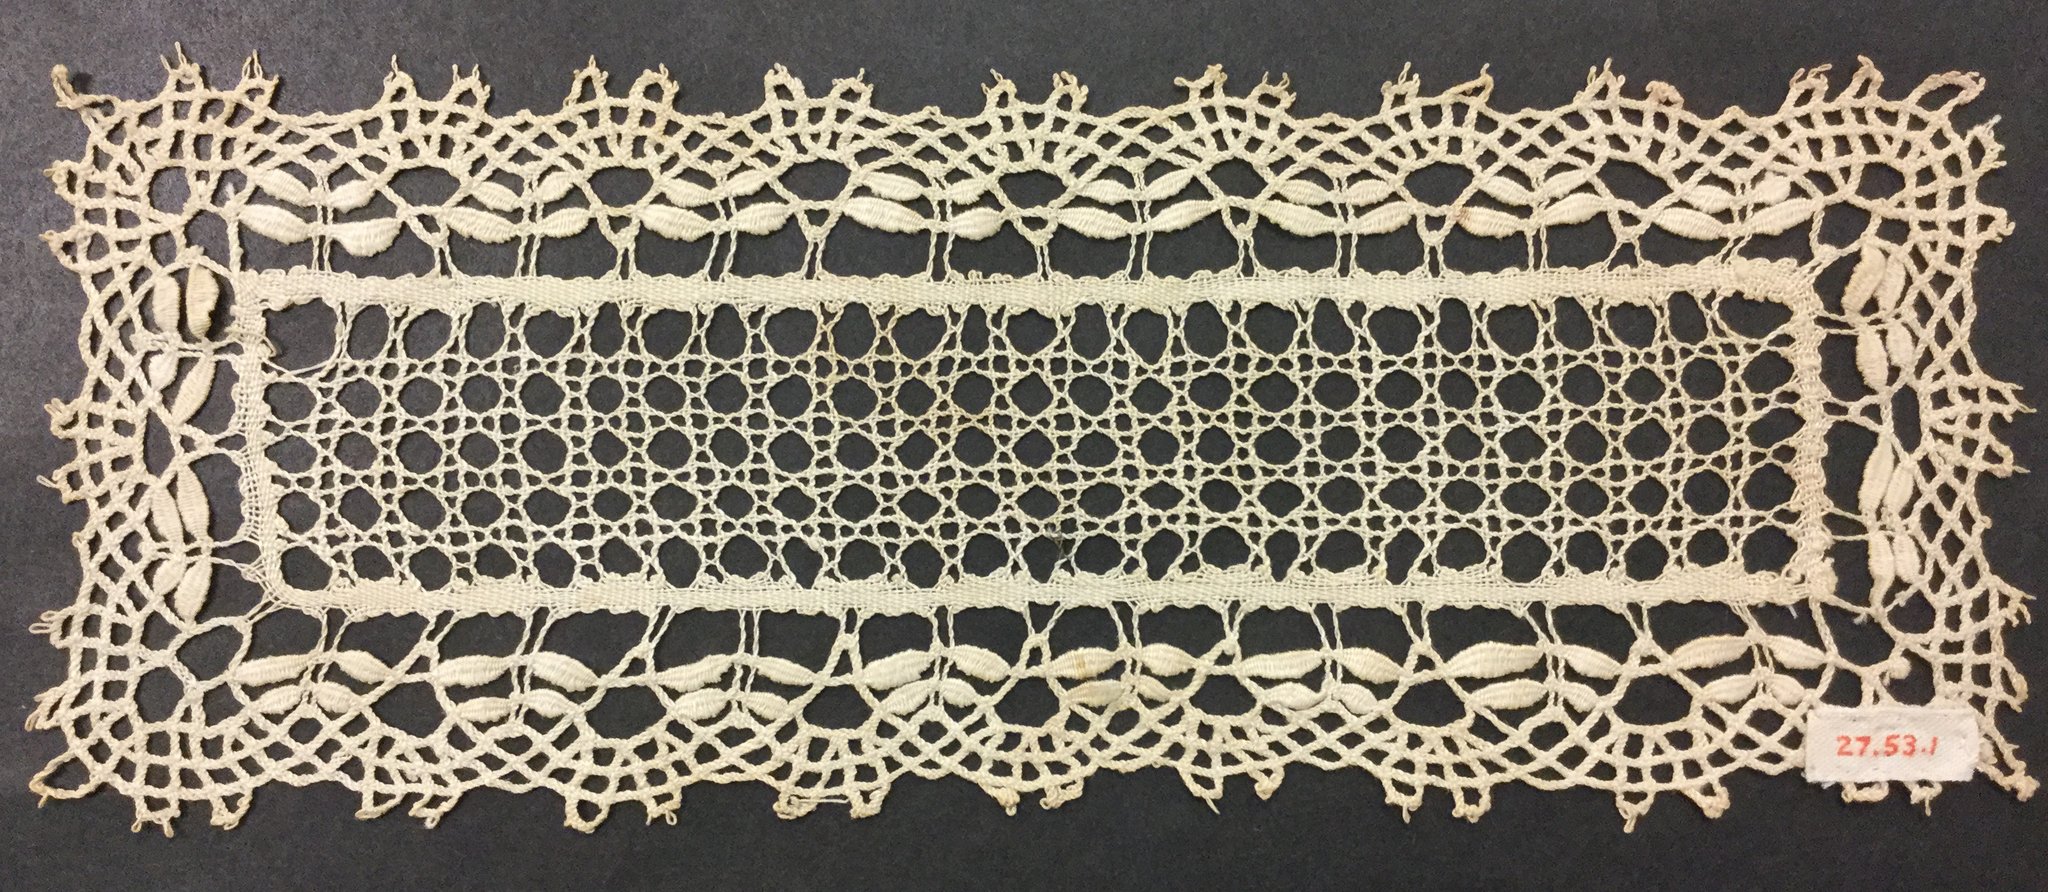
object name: cuff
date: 1801-1833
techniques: lace